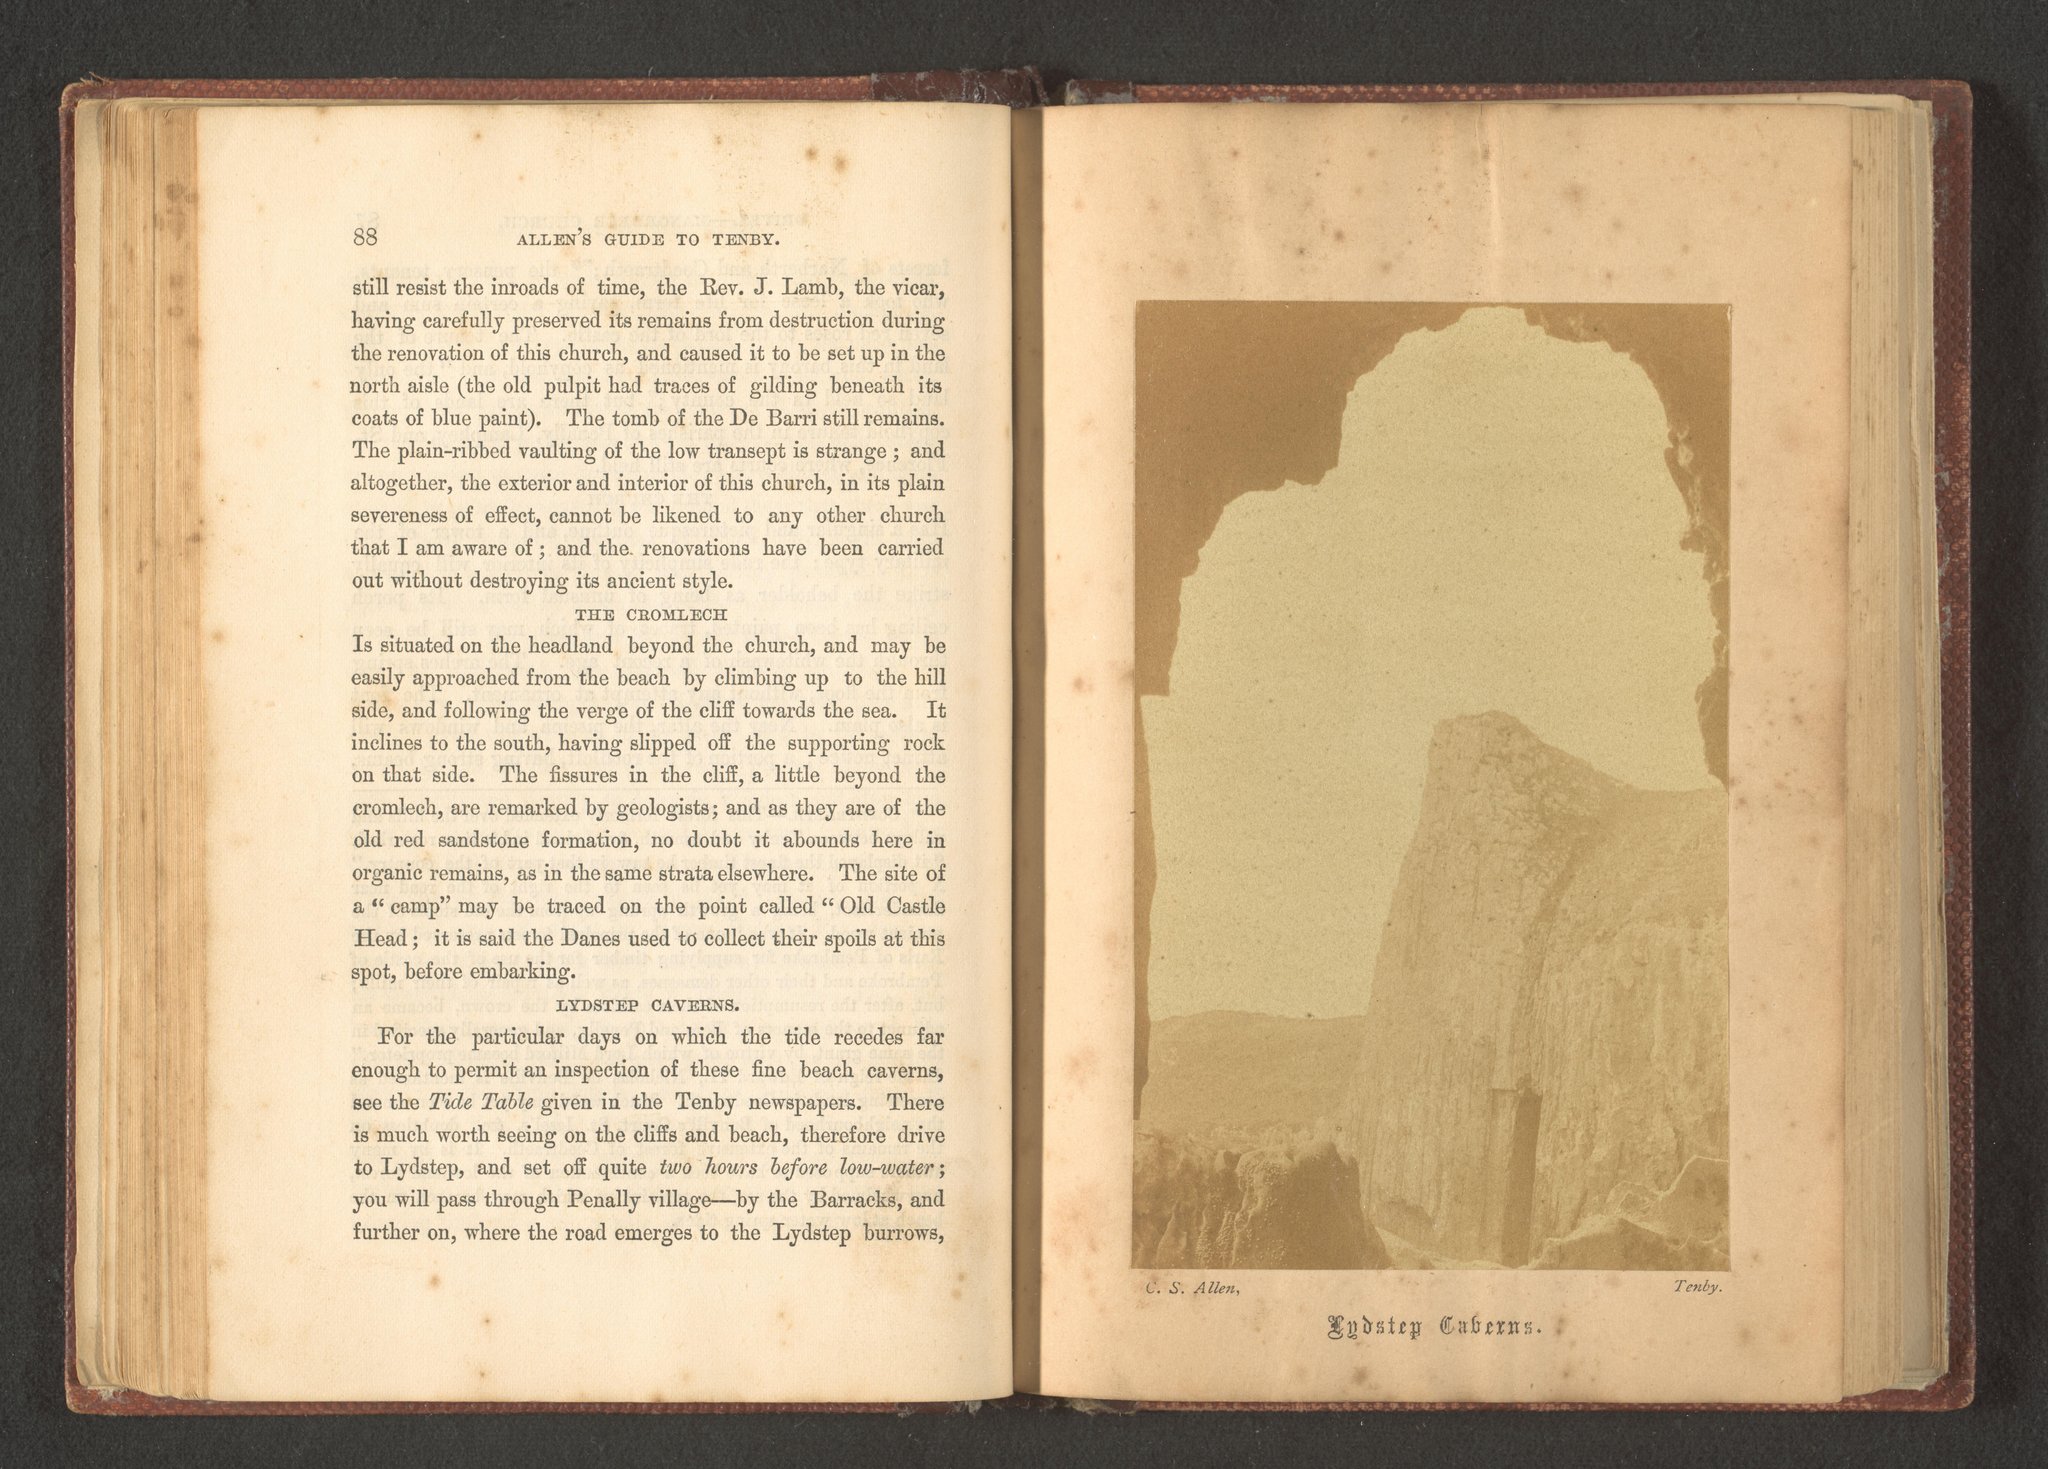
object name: photograph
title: Gezicht op Lydstep Caverns bij Tenby, Wales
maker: charles allen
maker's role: fotograaf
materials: photographic support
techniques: albumen print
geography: tenby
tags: cave, grotto